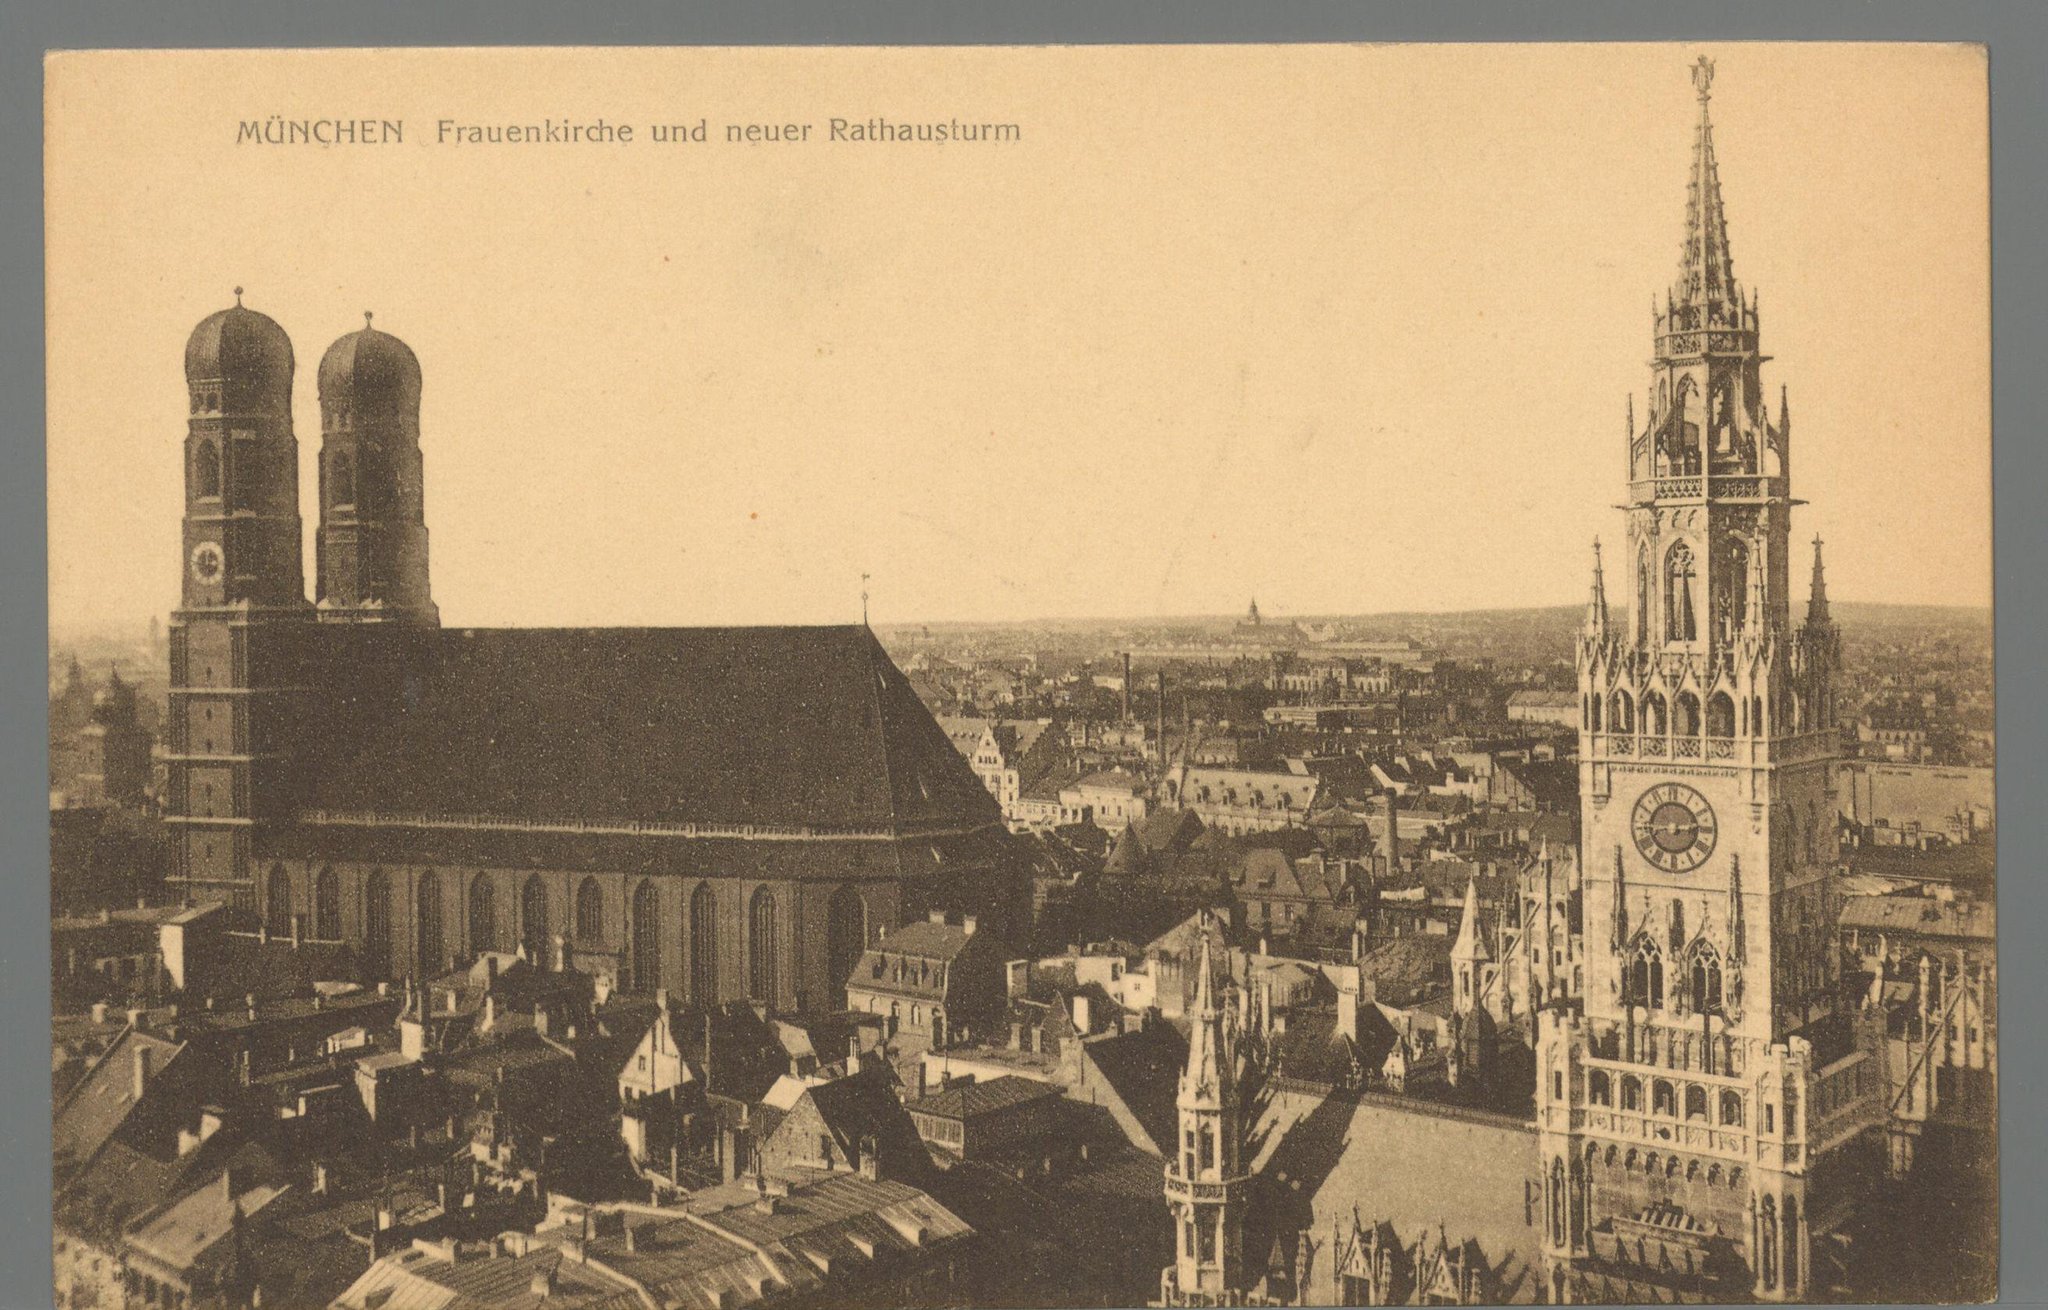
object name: photomechanical print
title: München. Frauenkirche und neuer Rathausturm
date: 1905-1930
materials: cardboard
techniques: photograph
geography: munich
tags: city-view, and landscape with man-made constructions, church (exterior), townhall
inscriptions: inscription: ‘W.H.D.’